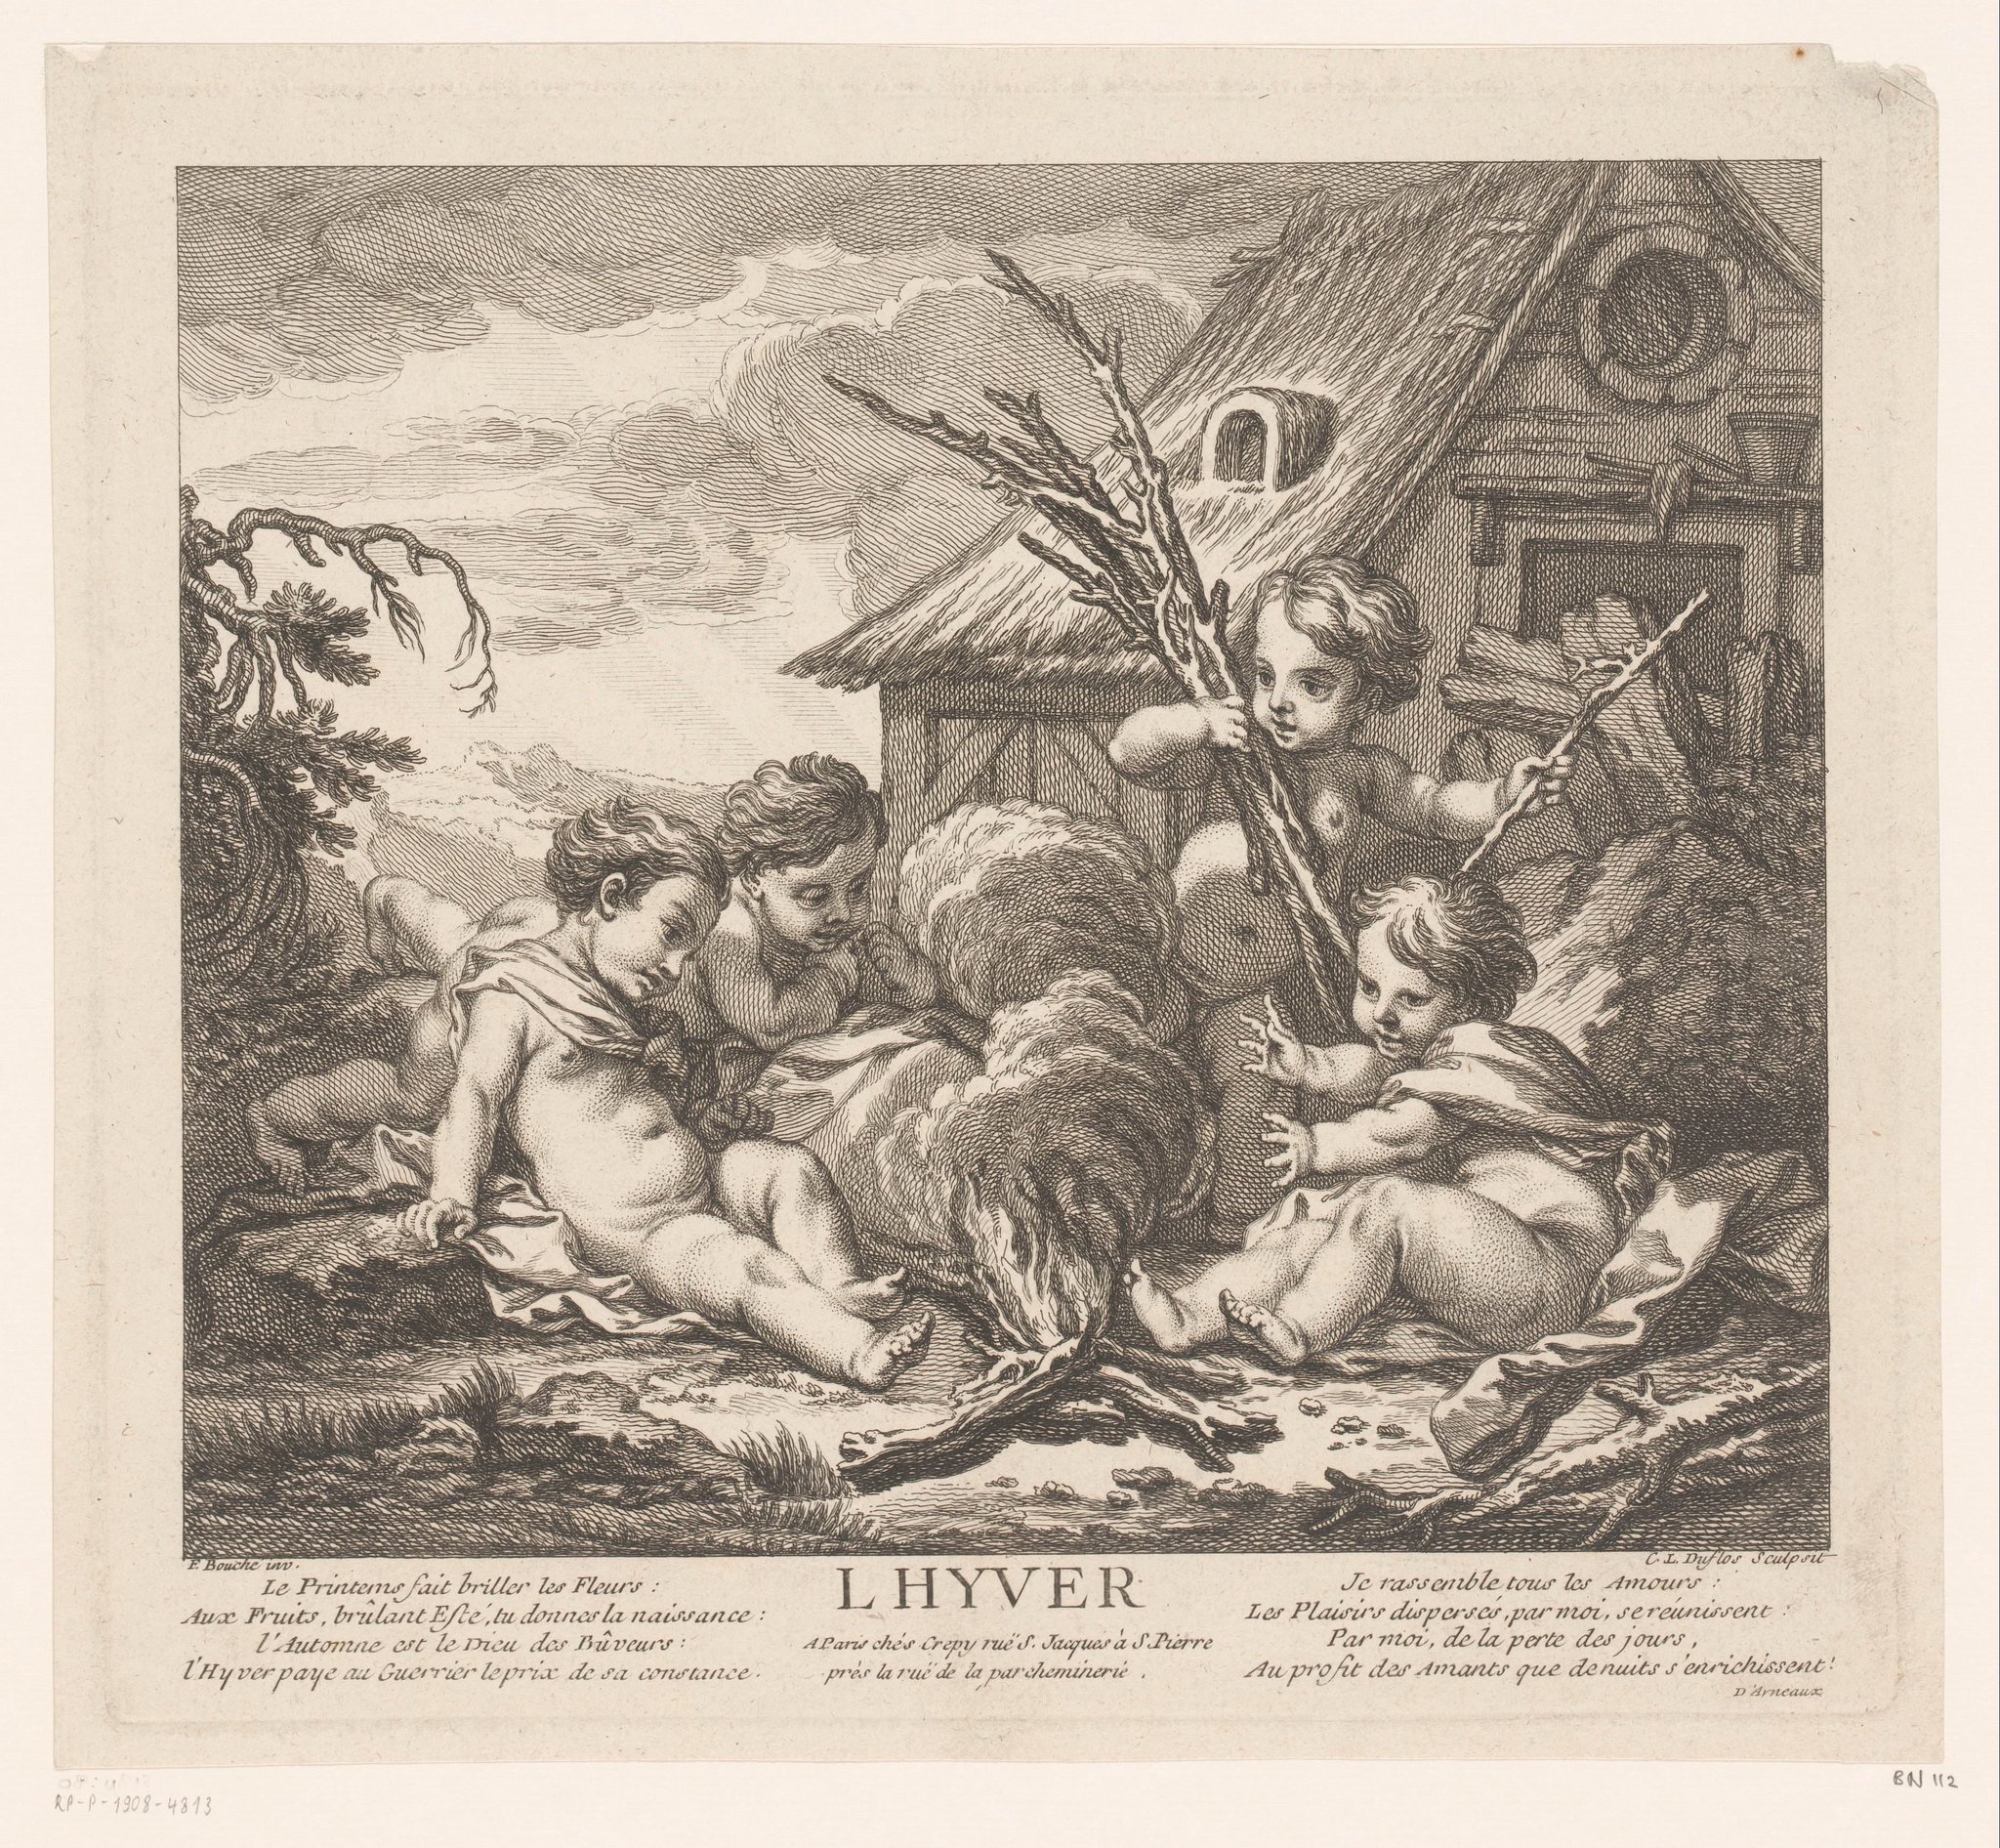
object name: print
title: Vier seizoenen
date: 1710-1786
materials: paper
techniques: engraving, etching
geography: france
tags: winter ~ human activities (the four seasons of the year)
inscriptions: collector's mark: Lugt 2228